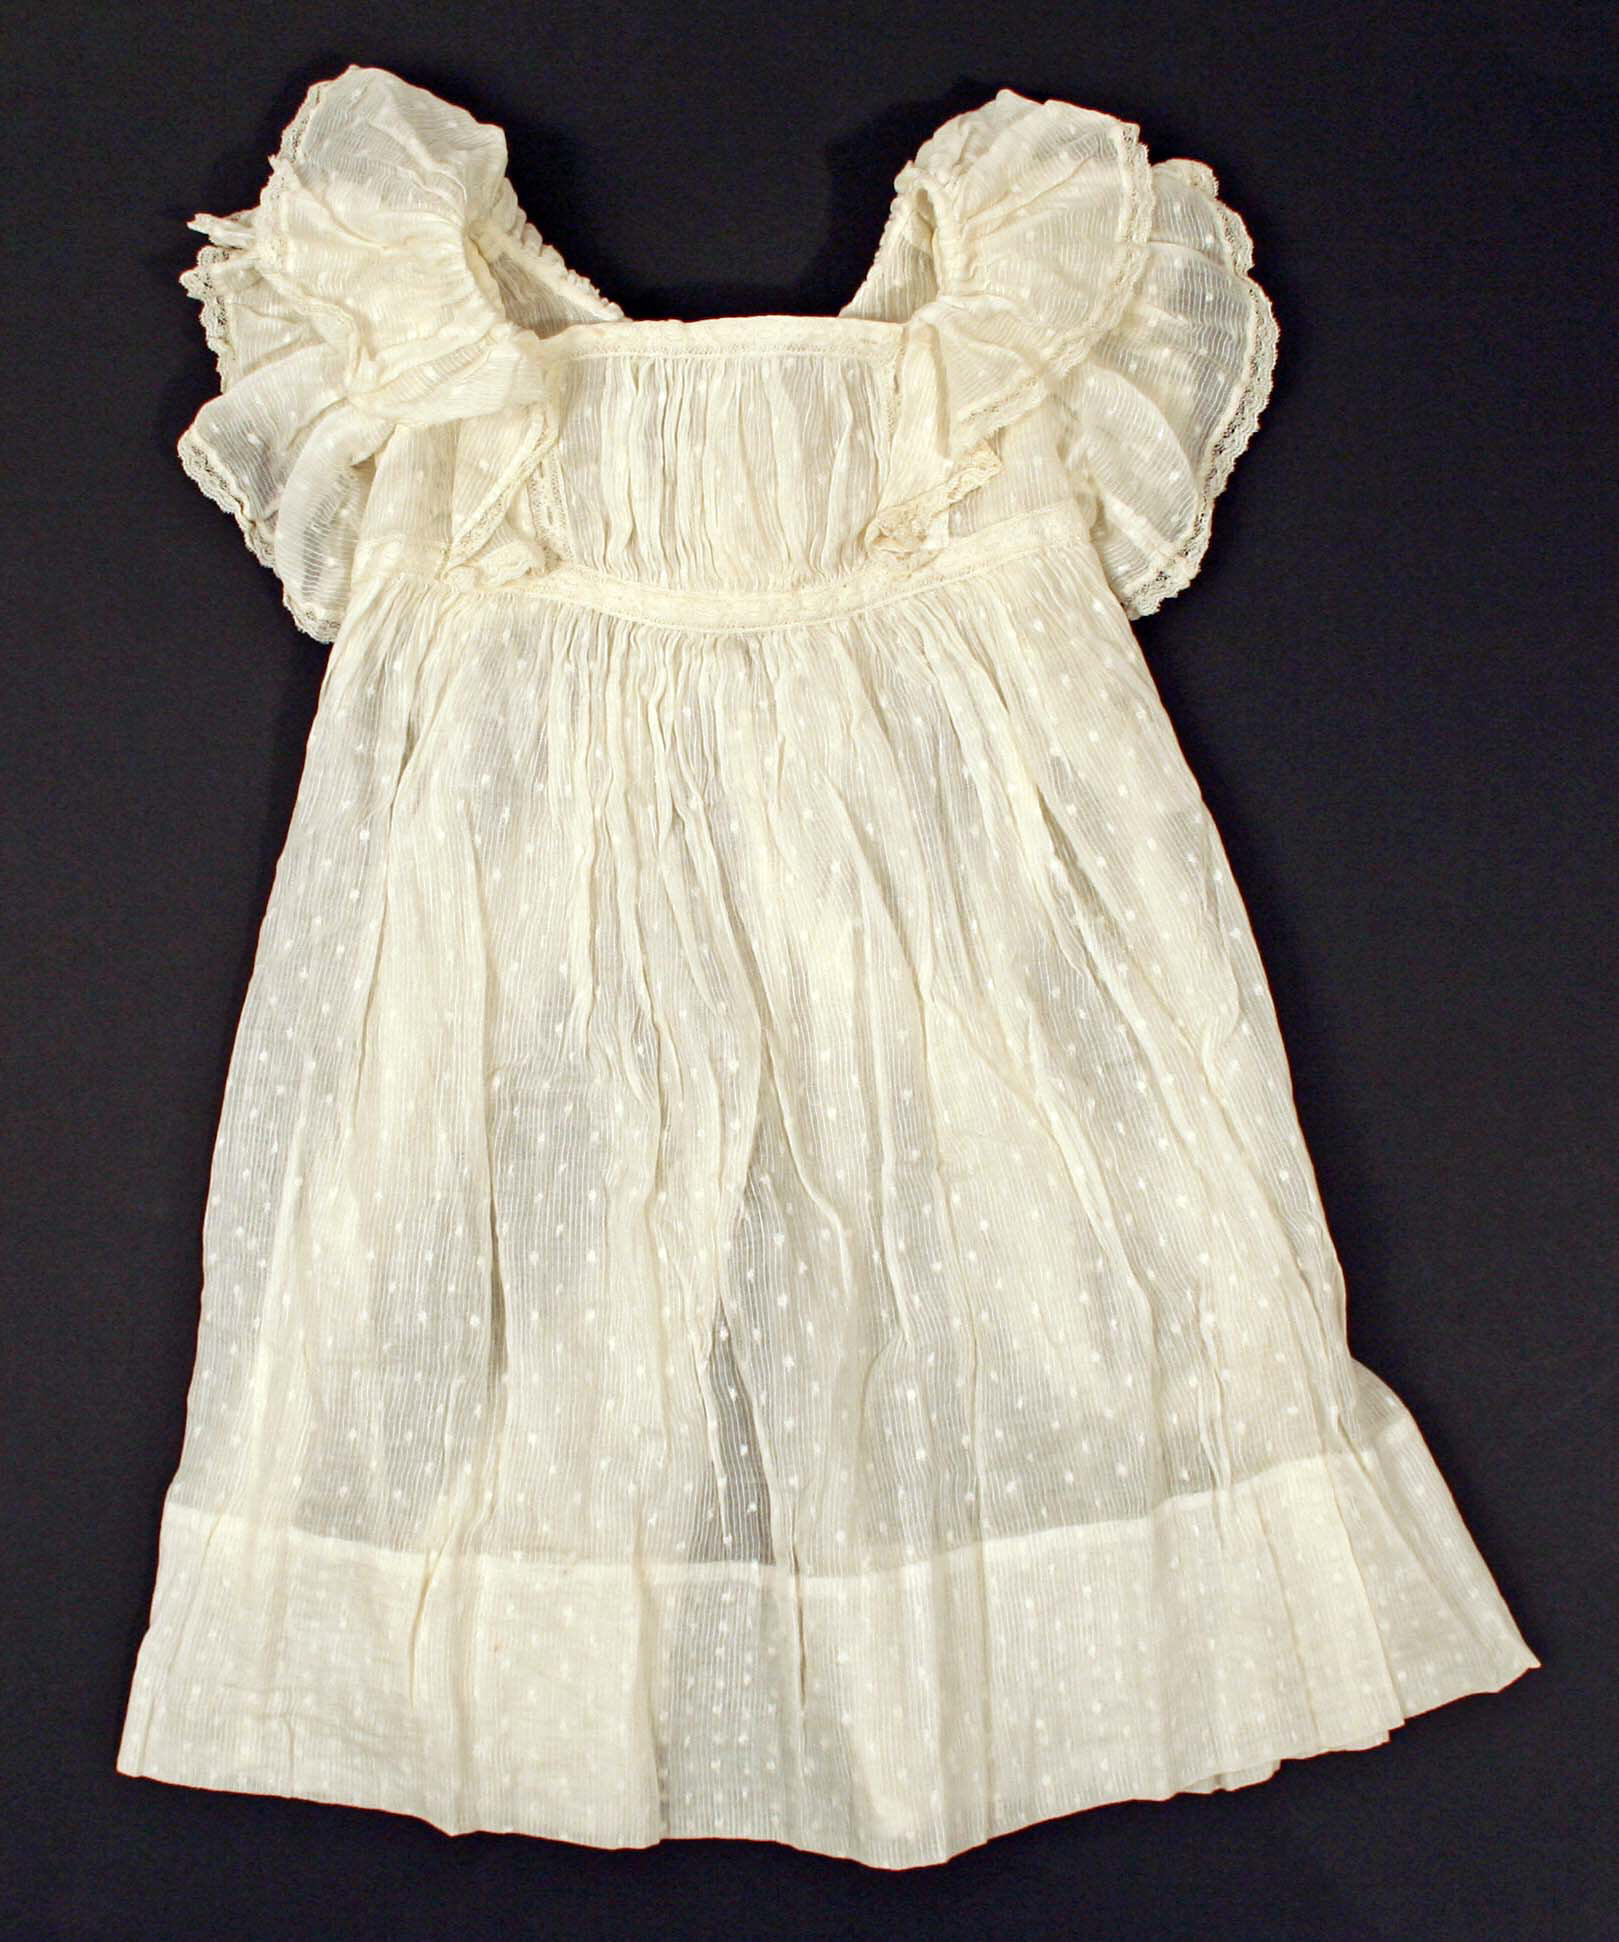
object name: pinafore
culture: american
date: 1898